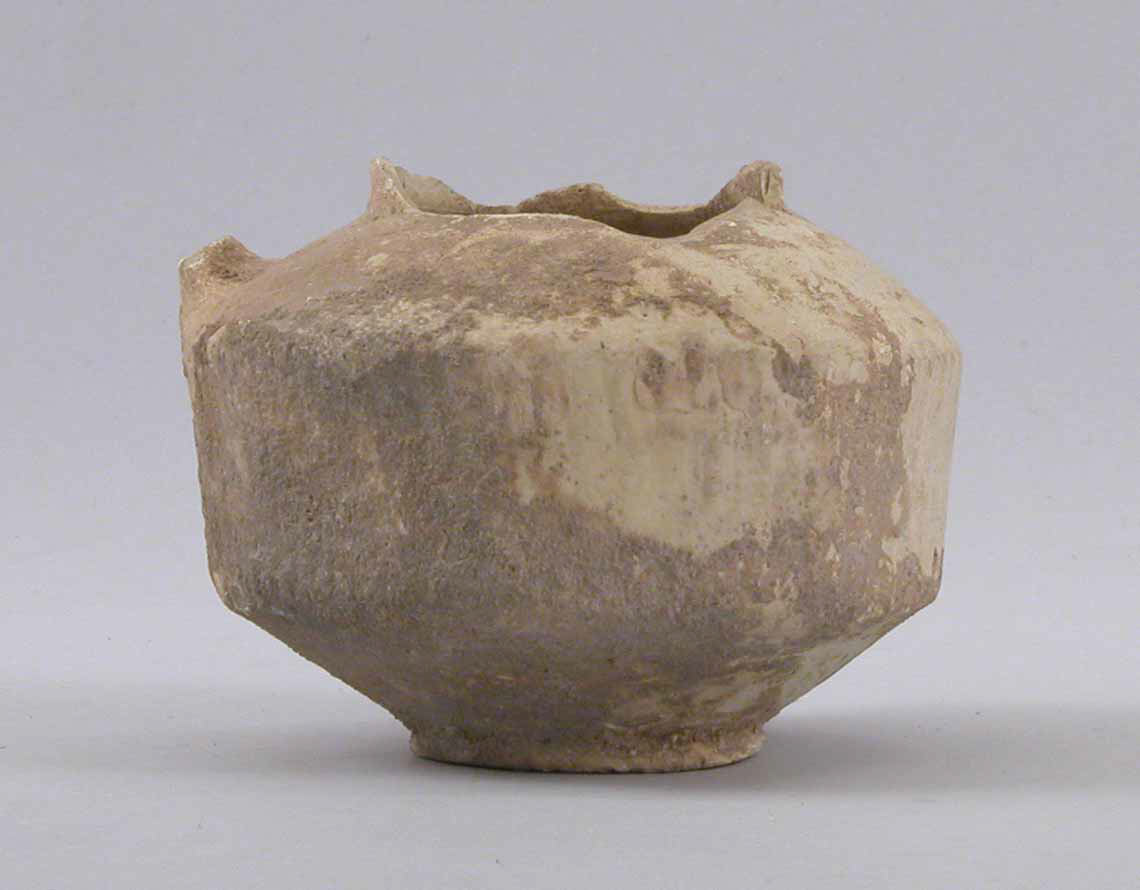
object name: ewer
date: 701-800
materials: earthenware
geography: iraq